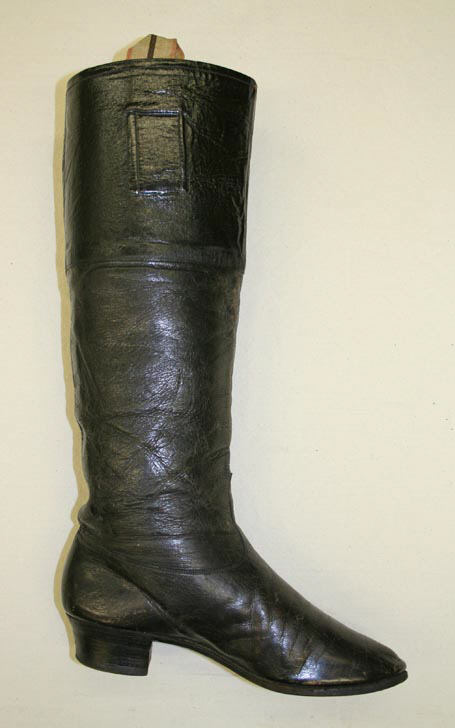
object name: boot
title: Boots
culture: american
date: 1875-1890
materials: leather